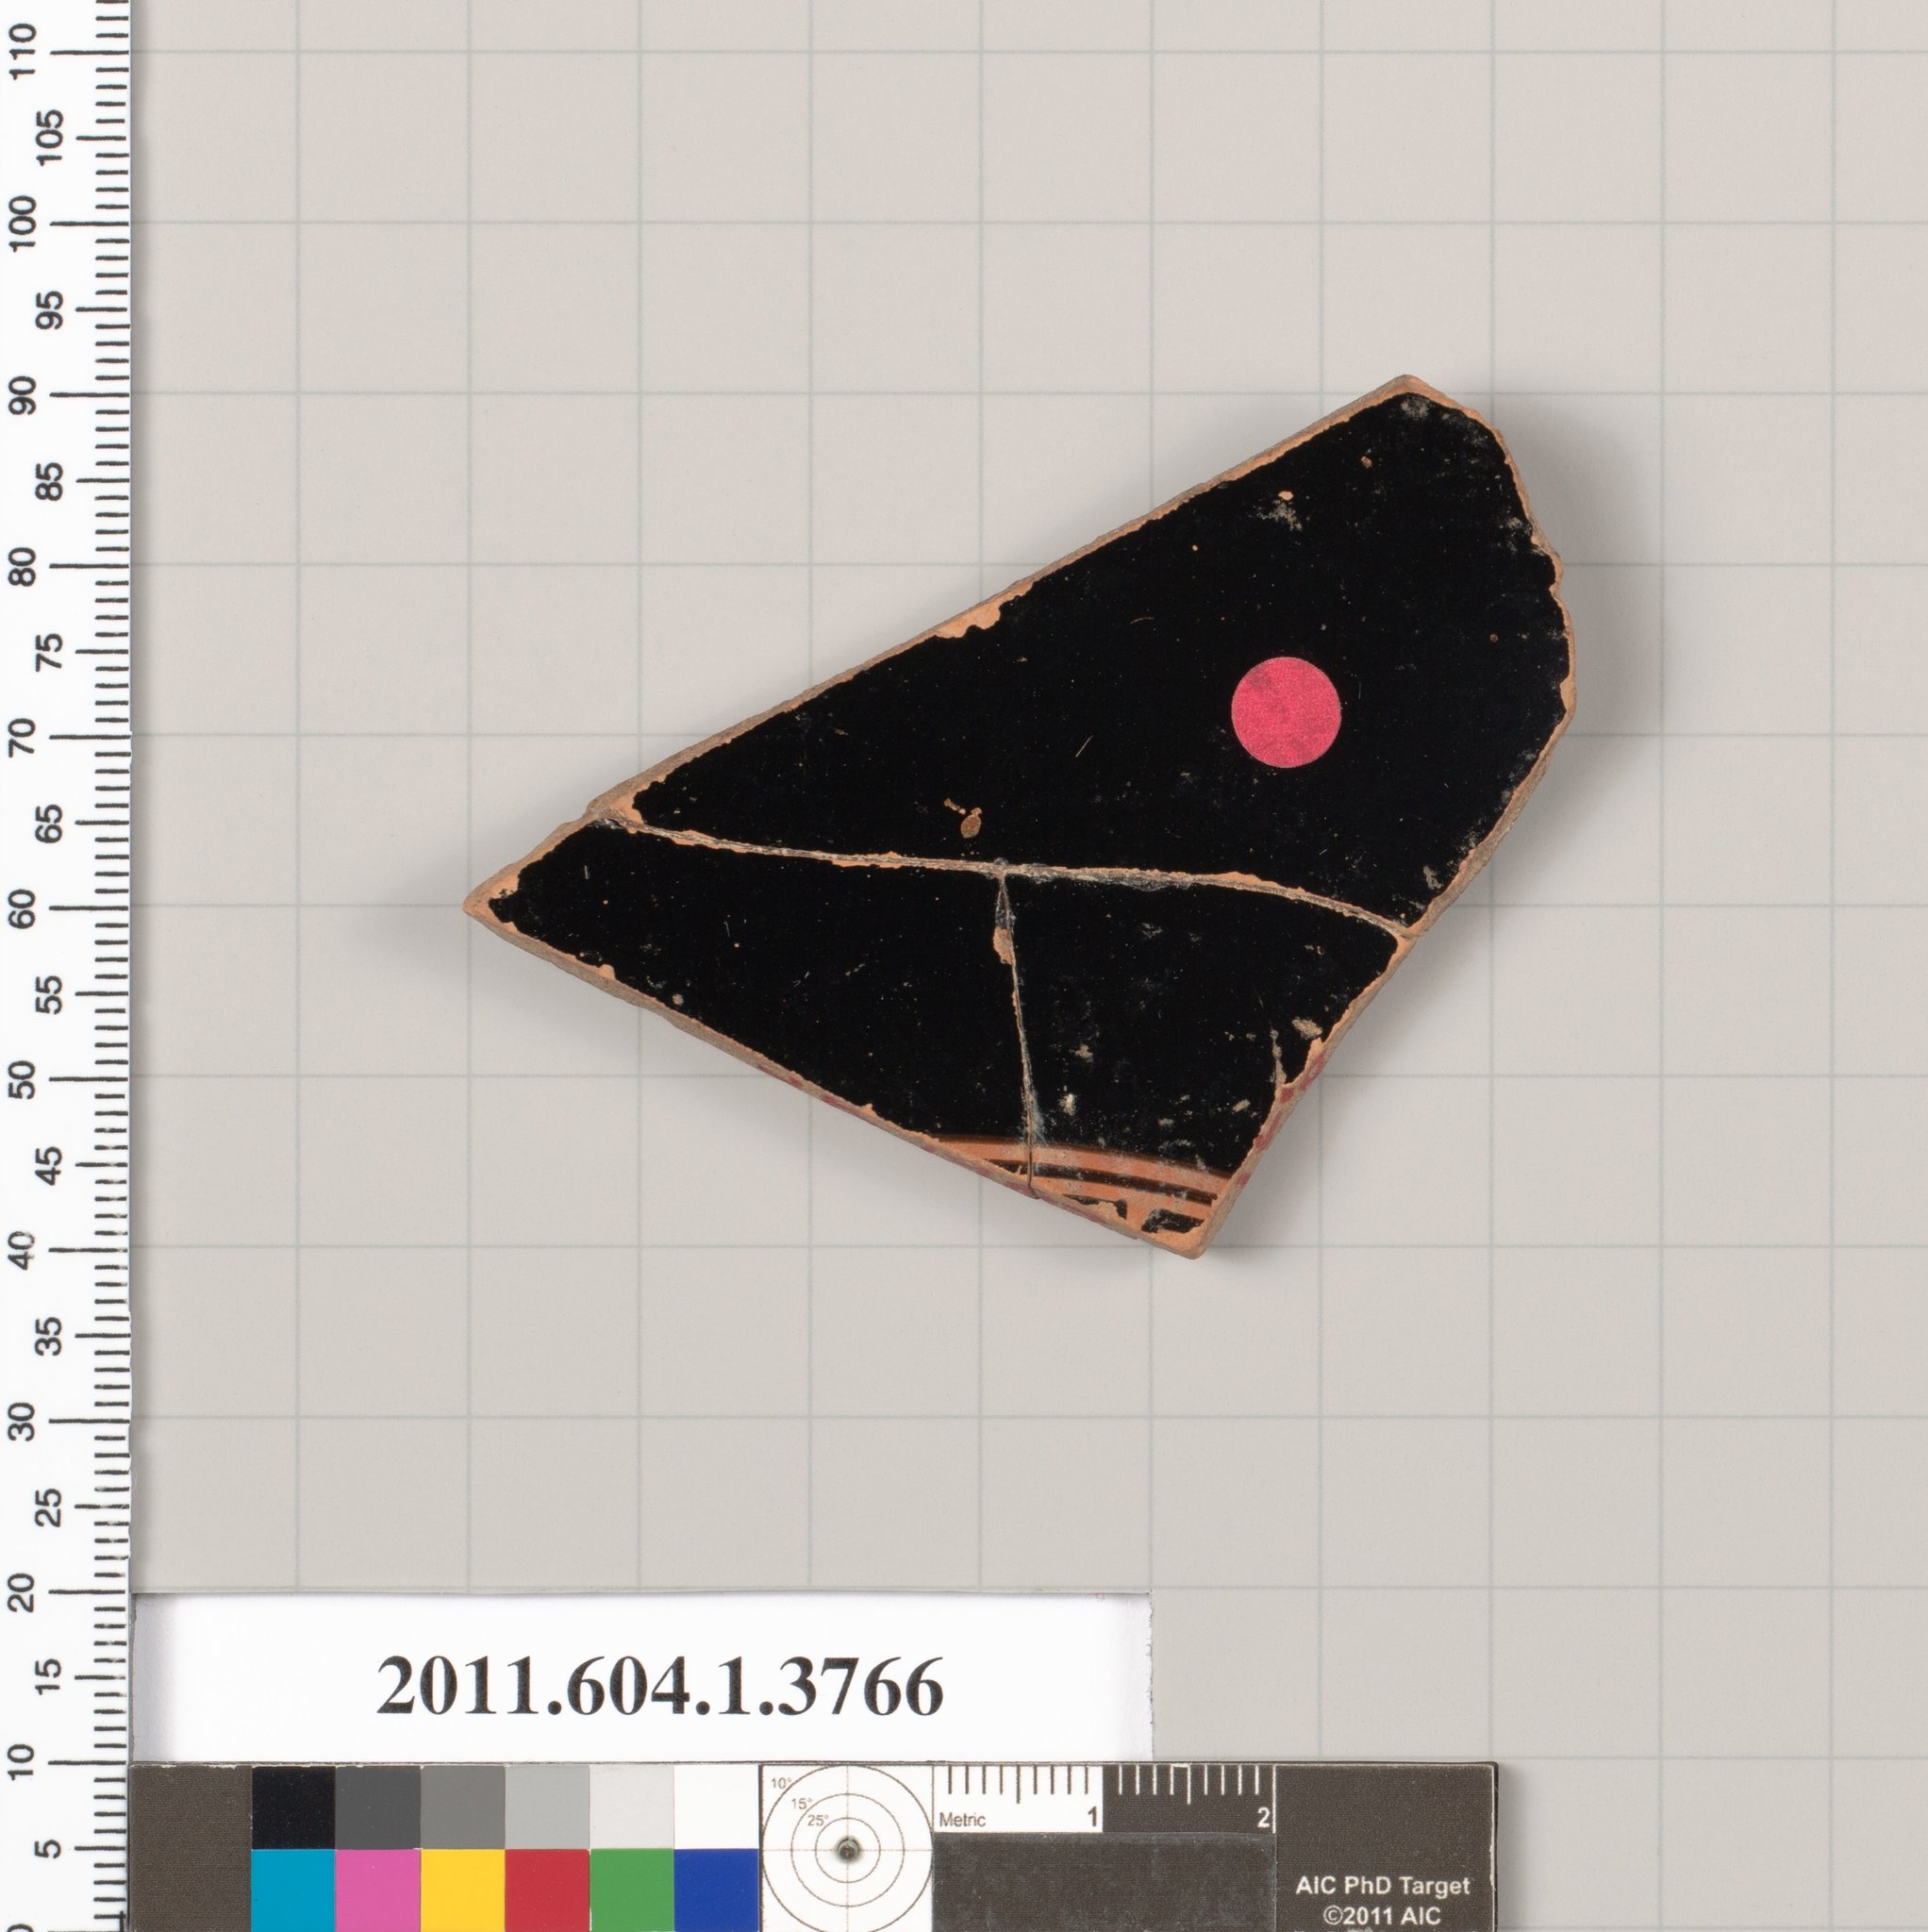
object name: kylix fragment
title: Terracotta fragment of a kylix (drinking cup)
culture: greek, attic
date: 460-450 BCE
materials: terracotta